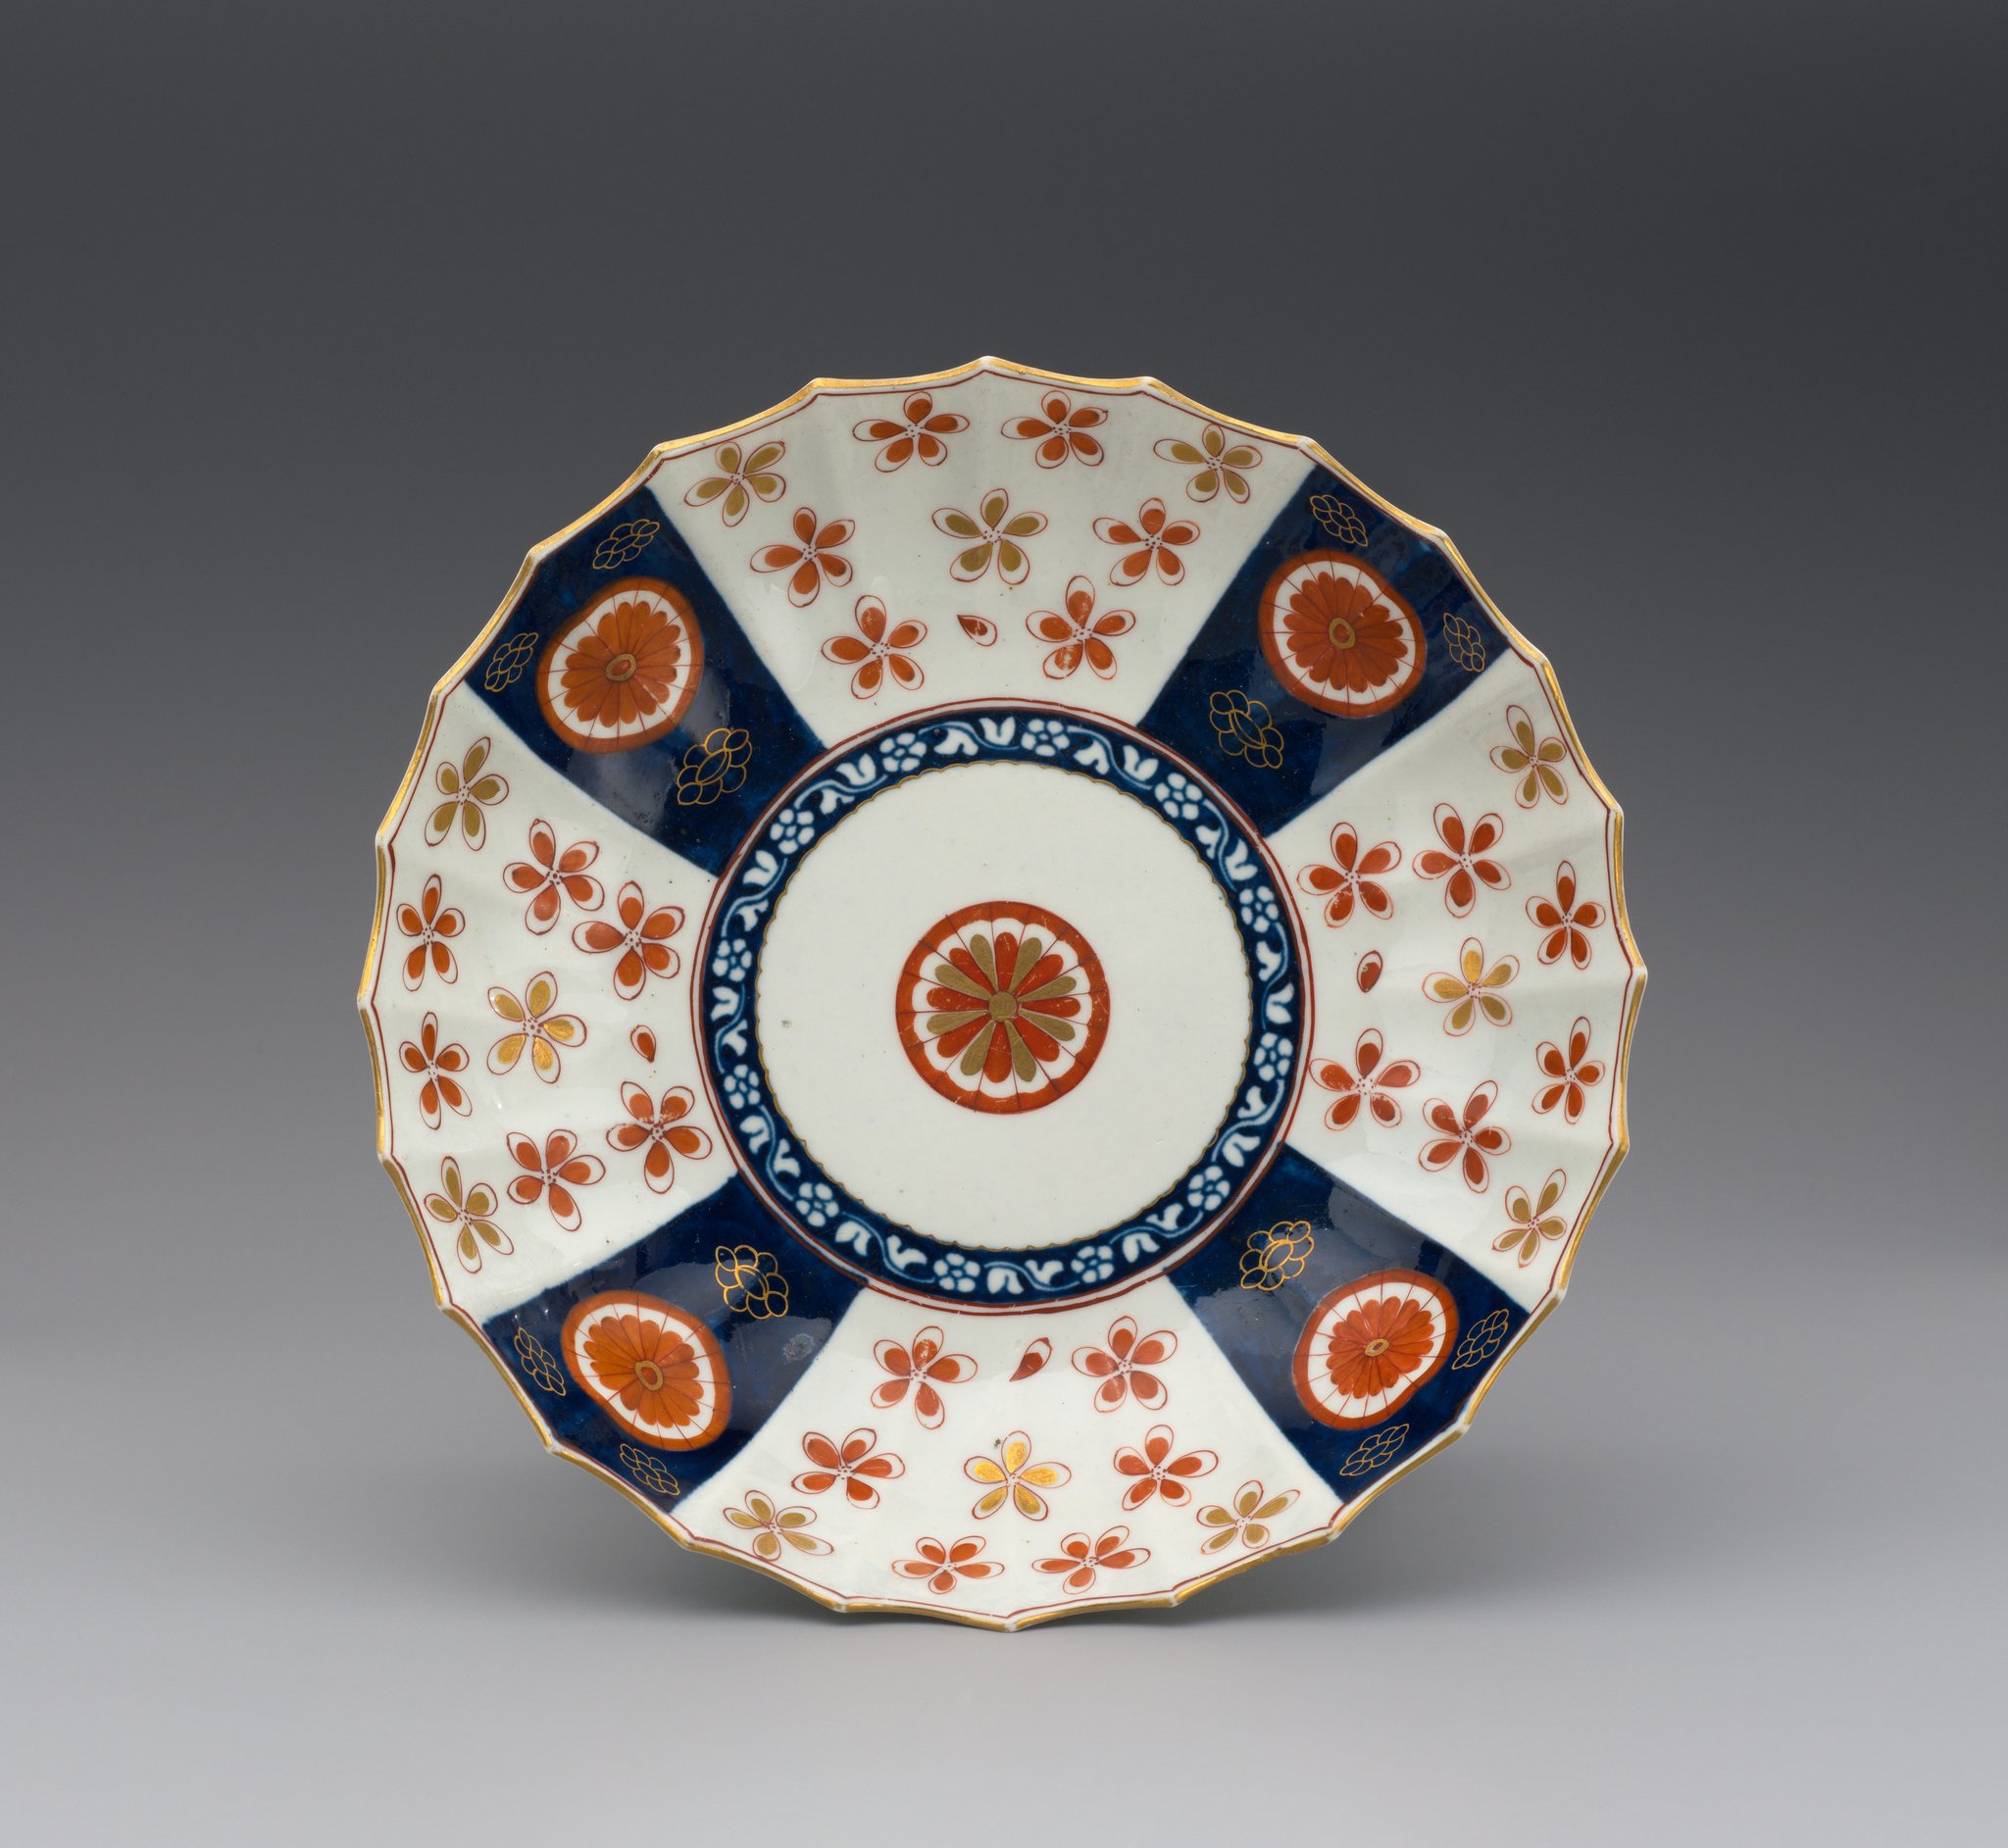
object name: dish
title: Dish (part of a service)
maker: worcester factory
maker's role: factory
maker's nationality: british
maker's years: 1751-2008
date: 1765-1775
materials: soft paste porcelain